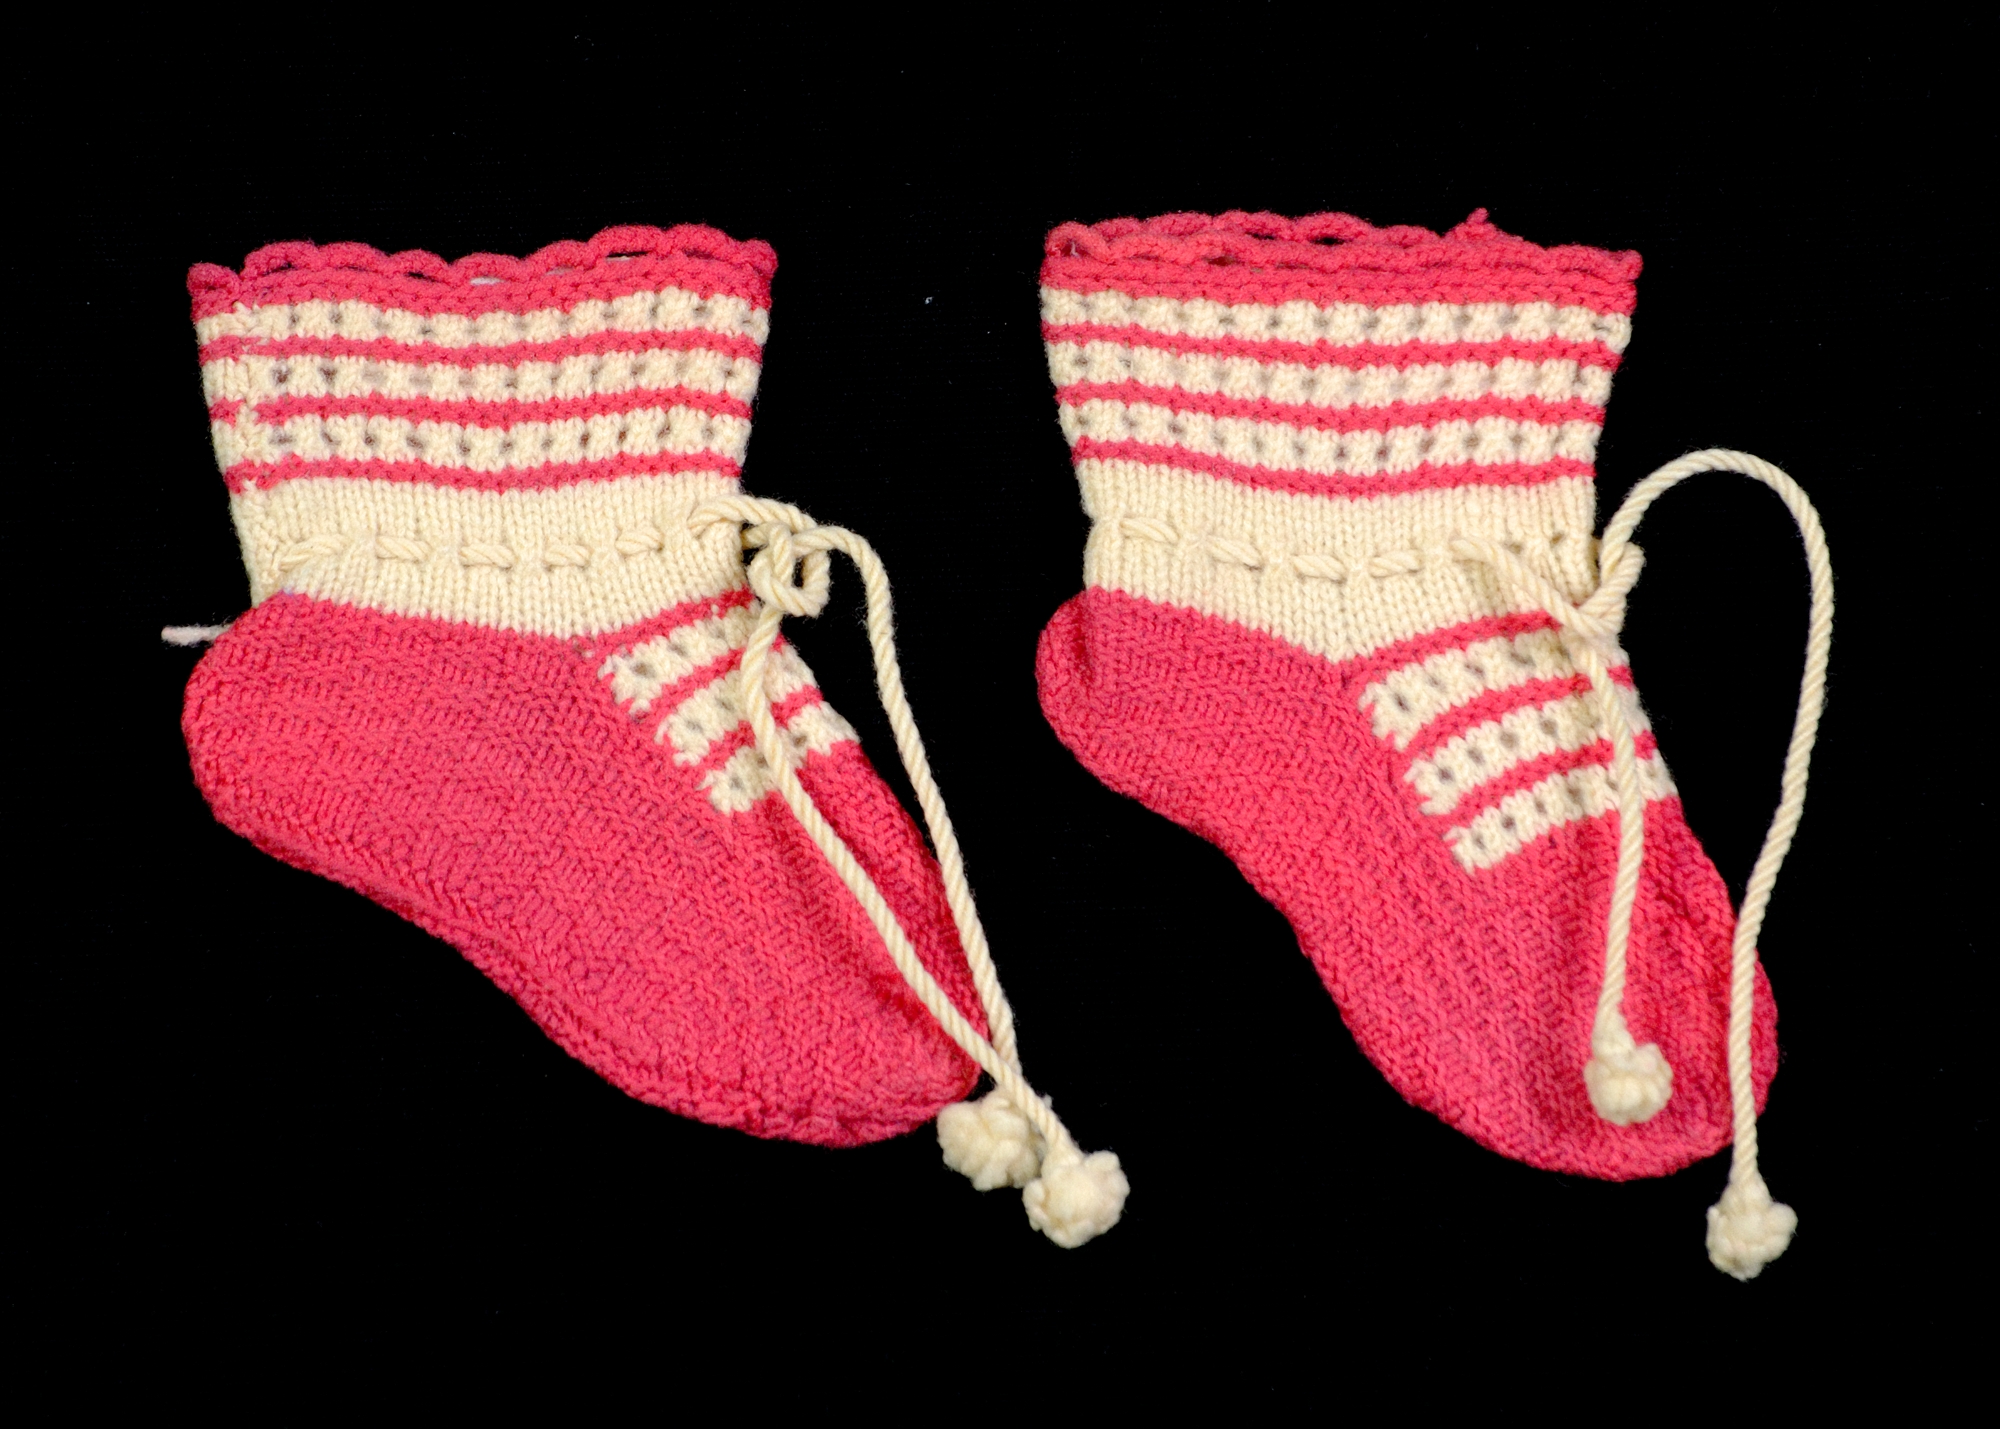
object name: bootee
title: Bootees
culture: american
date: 1850-1870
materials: wool